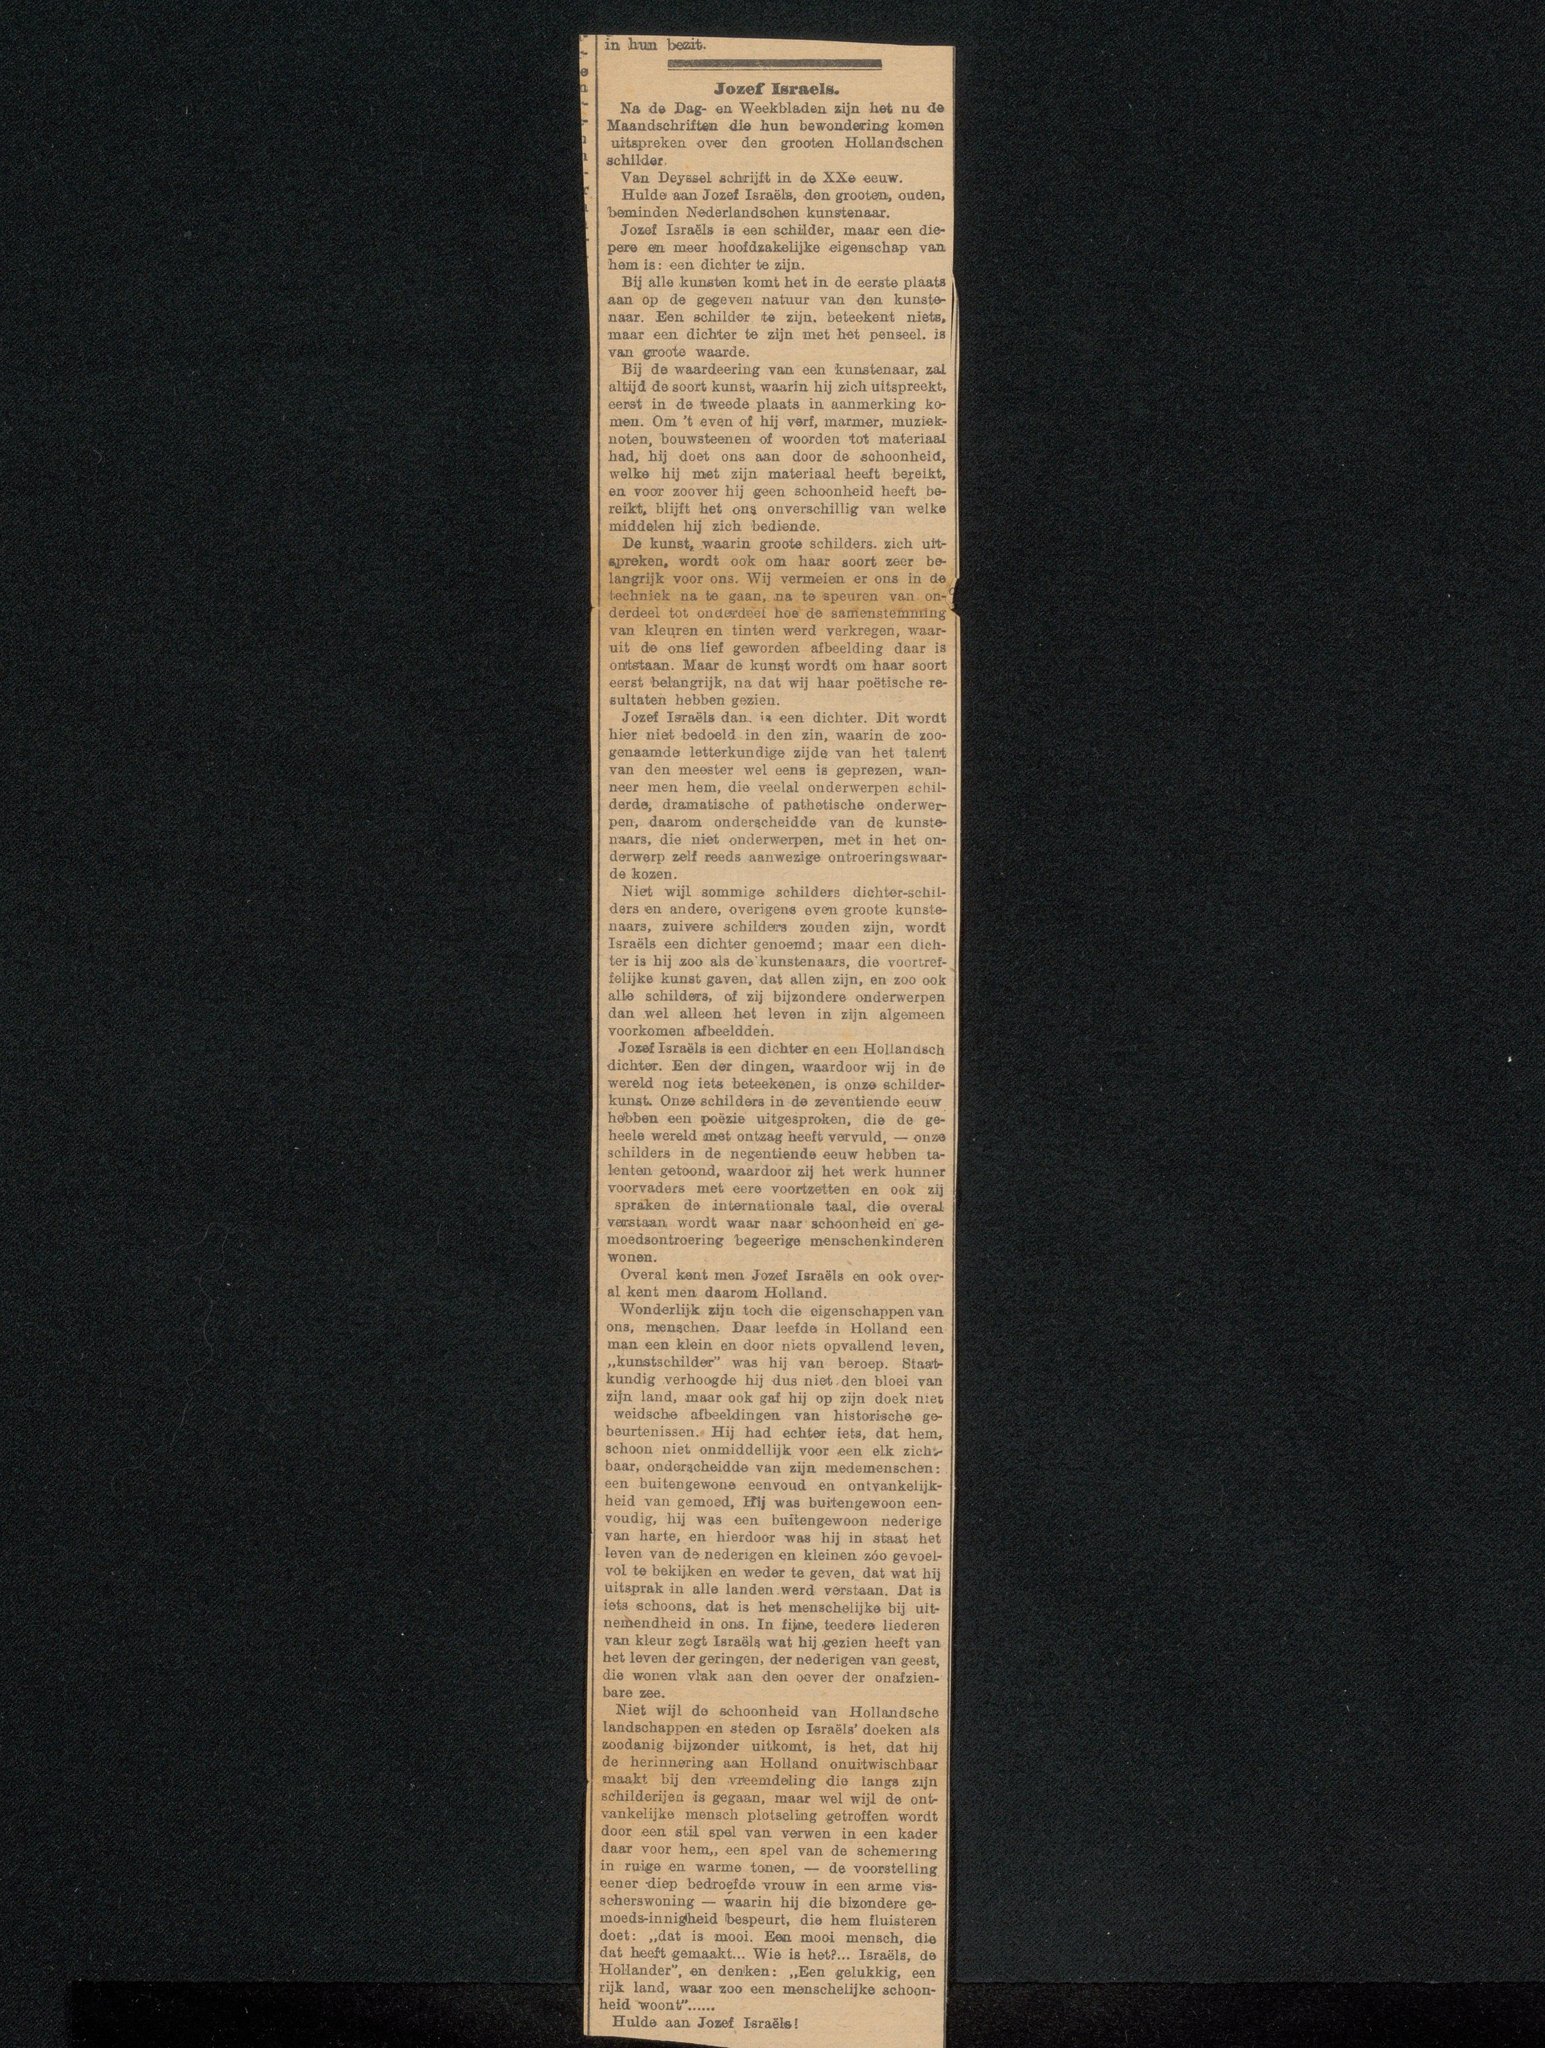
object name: newspaper clipping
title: Krantenknipsel uit archief Philip Zilcken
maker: Anonymous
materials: paper, ink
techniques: printing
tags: the hague, painter, print maker, draughtsman, jozef israëls, philip zilcken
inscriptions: collector's mark: ‘RPK’